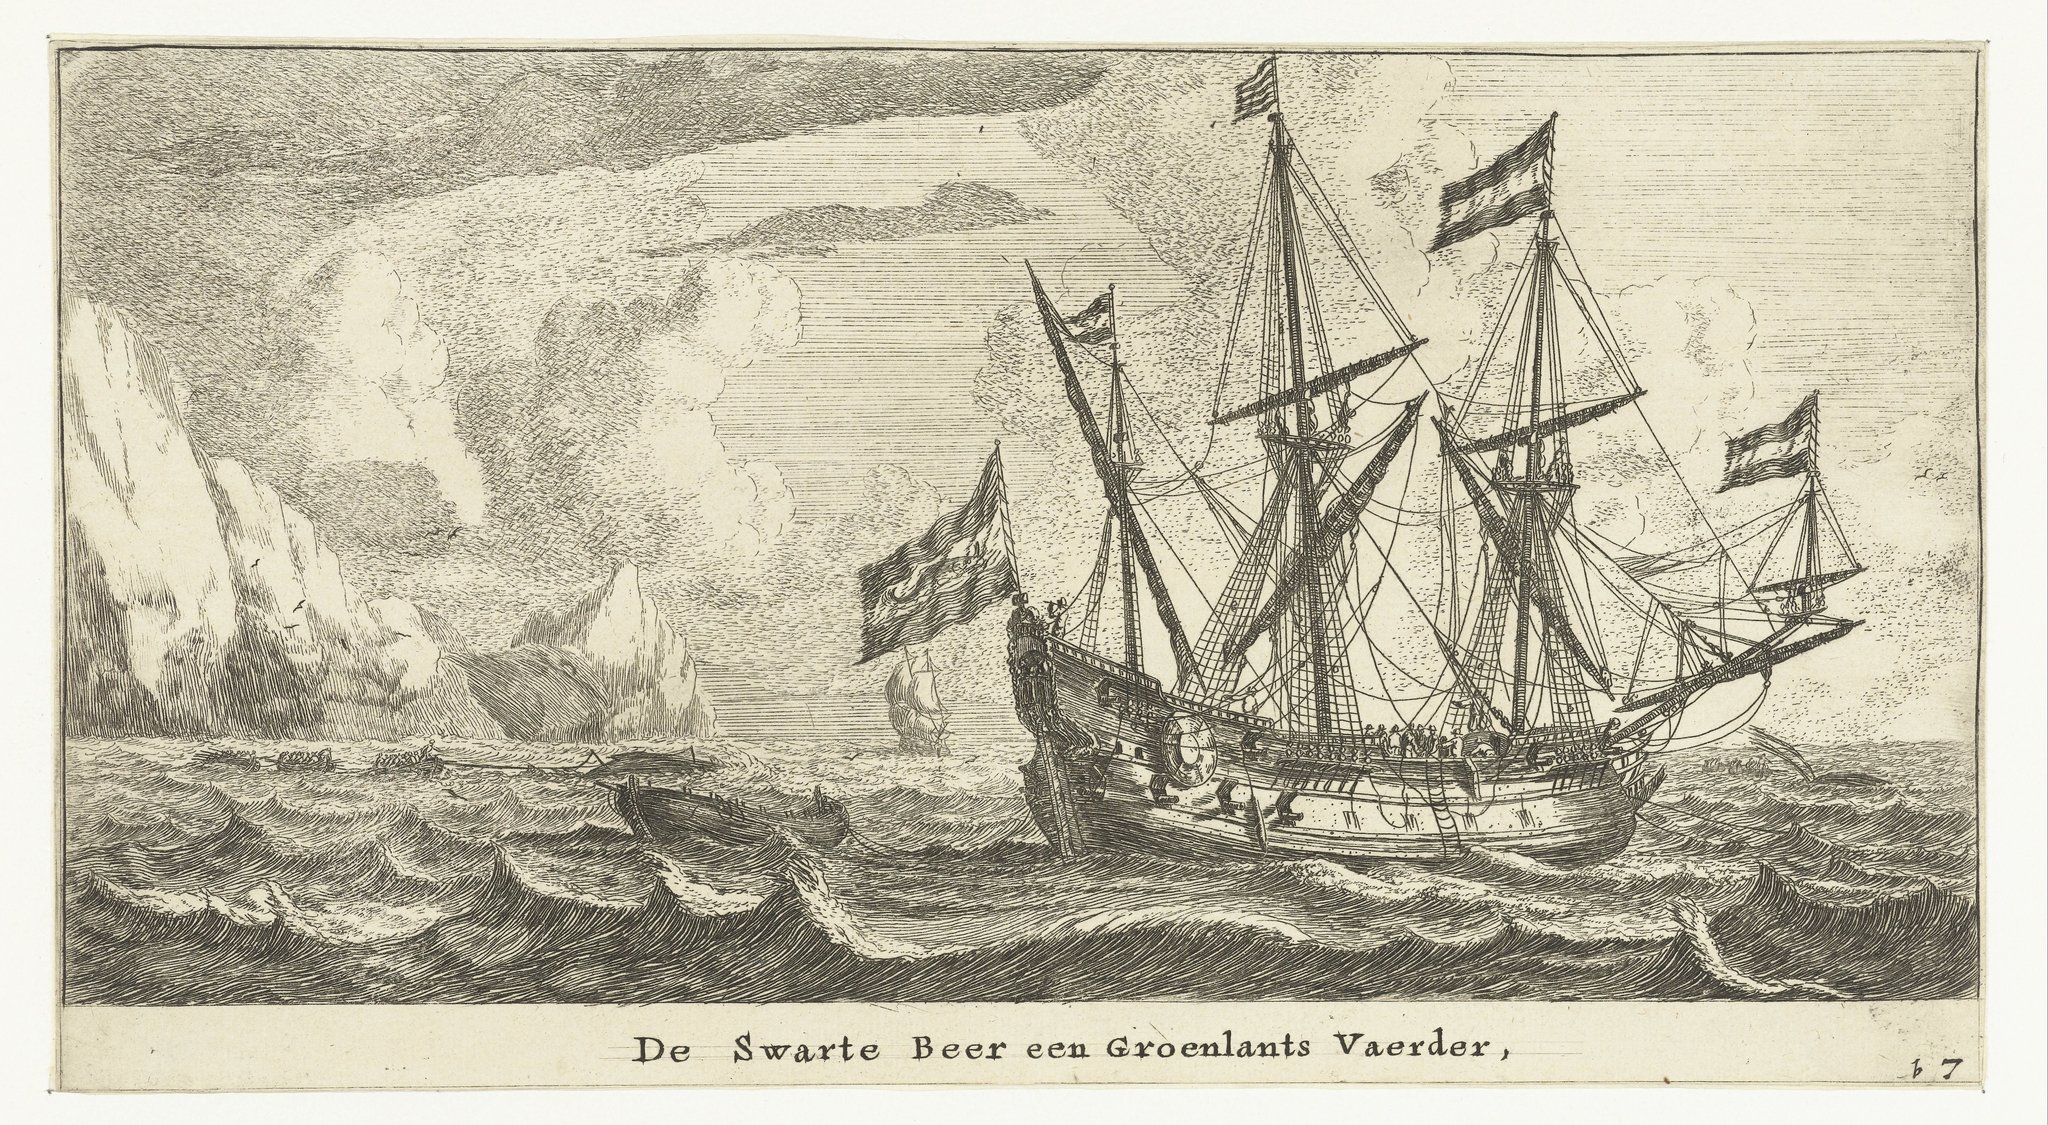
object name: print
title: De Swarte Beer een Groenlants Vaerder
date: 1652-1654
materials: paper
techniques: drypoint, etching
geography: netherlands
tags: sailing-ship, sailing-boat, whale fishery, whaling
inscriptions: collector's mark: Lugt 12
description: De Zwarte Beer, een koopvaardijschip varend op Groenland en een aantal roeiboten met mensen erin, jagend op walvissen. Op de achtergrond ijsbergen.